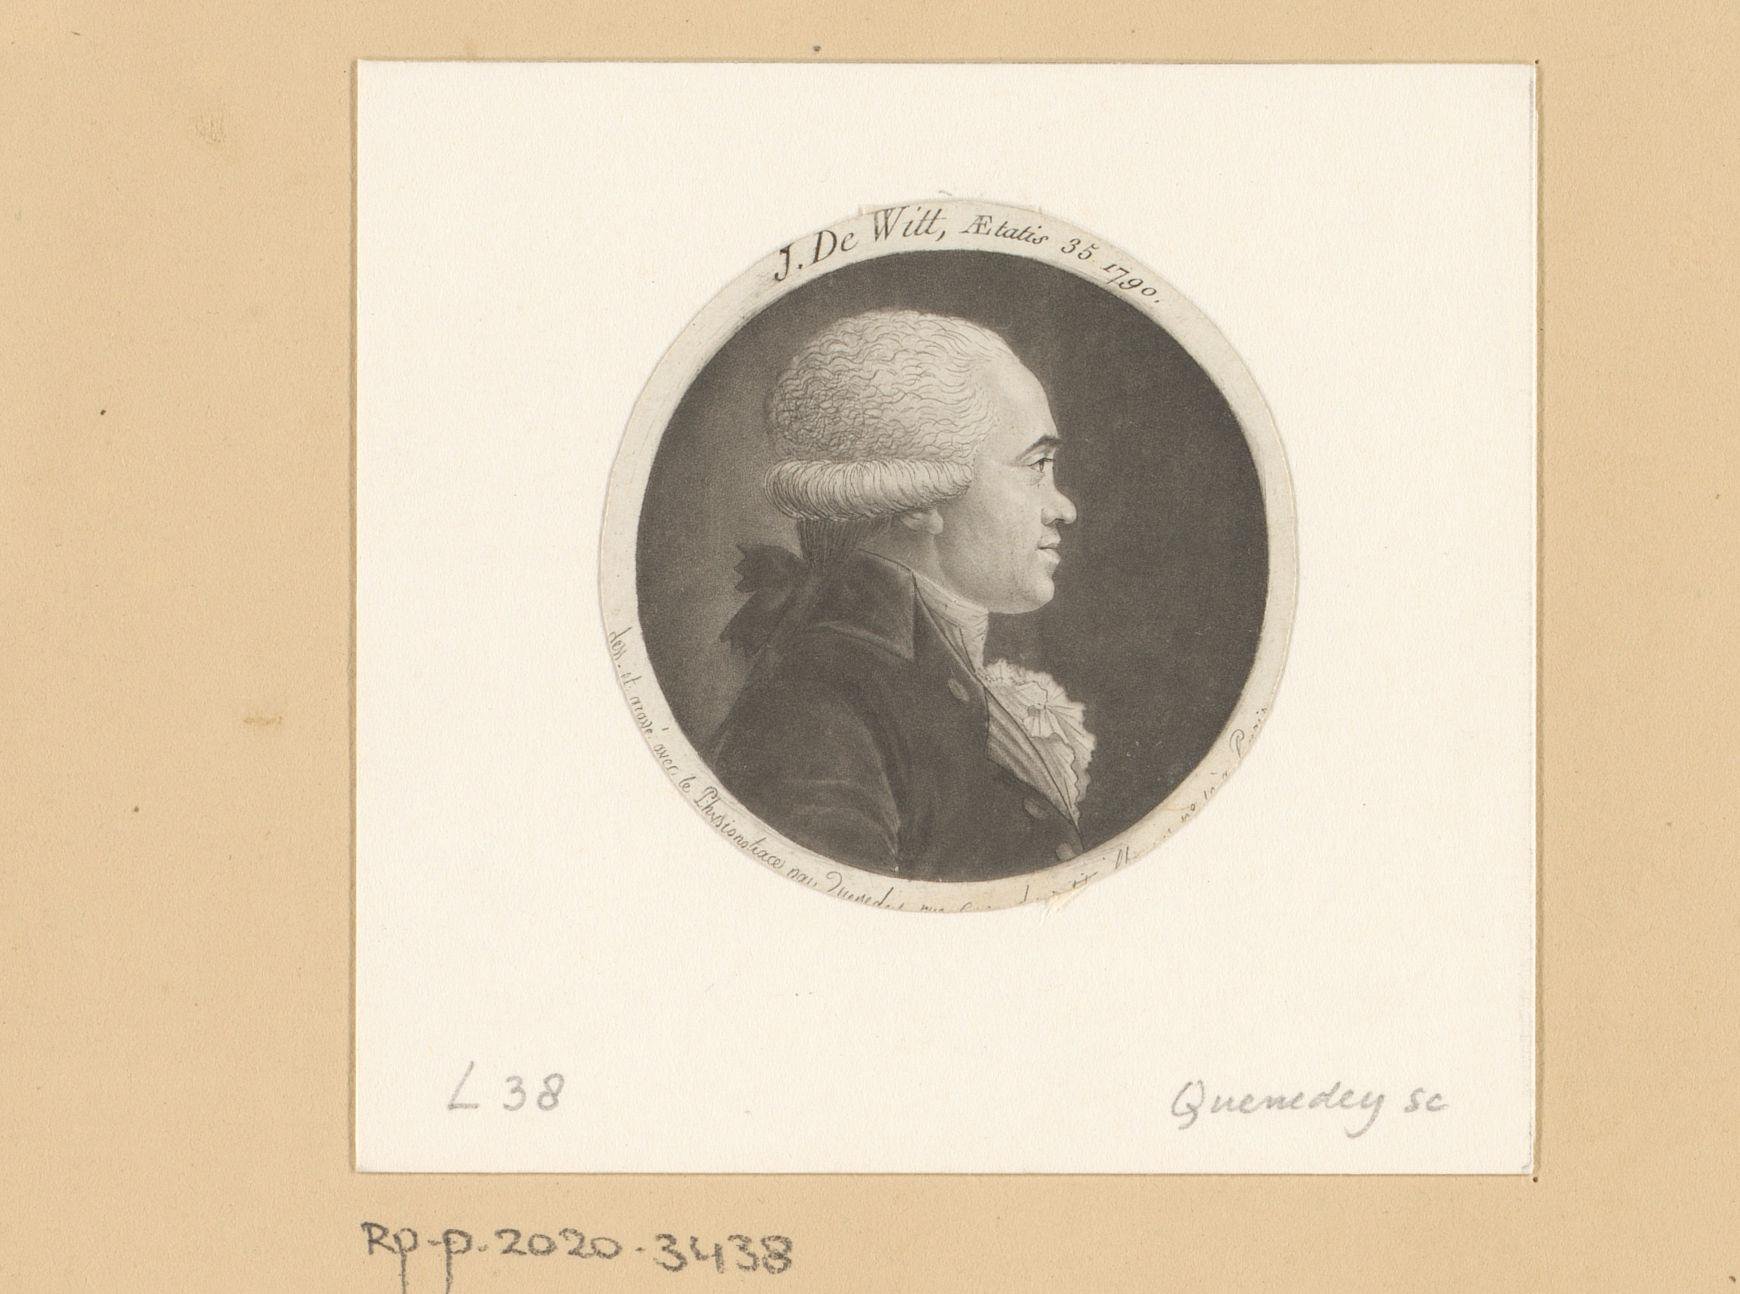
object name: physionotrace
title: Portret van Jan de Witt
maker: edme quenedey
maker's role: print maker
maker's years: 1756-1830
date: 1790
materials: paper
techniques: aquatint, etching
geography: paris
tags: amsterdam, france, silhouette-apparatus, 'physionotrace', historical persons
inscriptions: collector's mark: Lugt 2228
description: Deze prent heeft het nummer L.38 in het fonds van Quenedey.